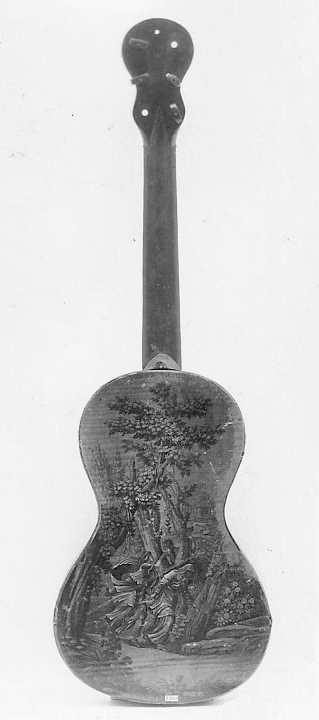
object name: guitar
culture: french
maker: bernard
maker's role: maker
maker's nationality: french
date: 1701-1800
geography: france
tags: women